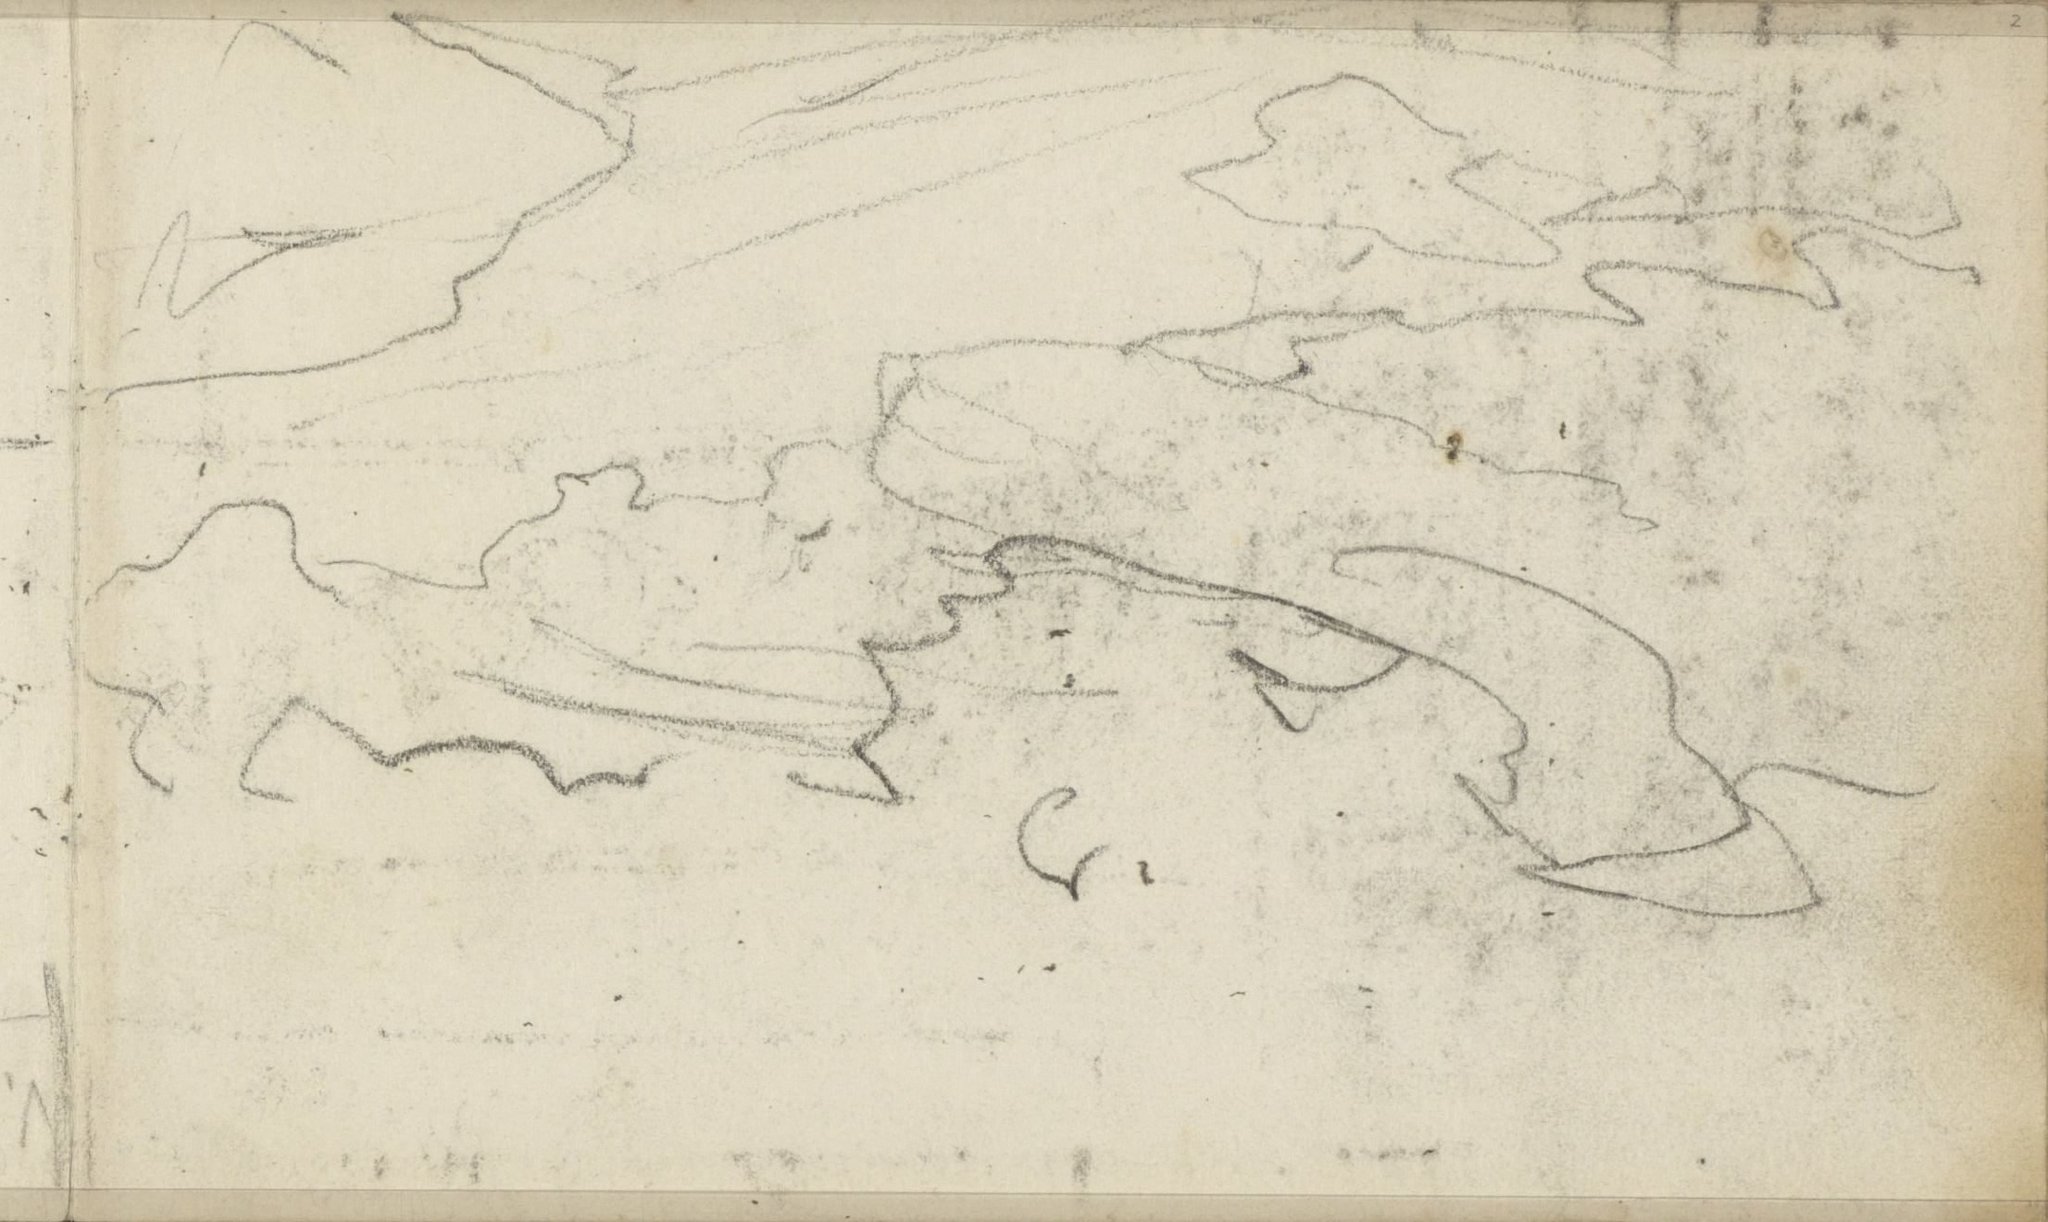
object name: sketchbook leaf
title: Wolkenlucht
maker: george hendrik breitner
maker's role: draughtsman, painter, print maker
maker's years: 1857-1923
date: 1884-1886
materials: chalk, paper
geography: the hague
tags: clouds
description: Pagina 2, vrij schutblad, uit een schetsboek met 35 bladen.